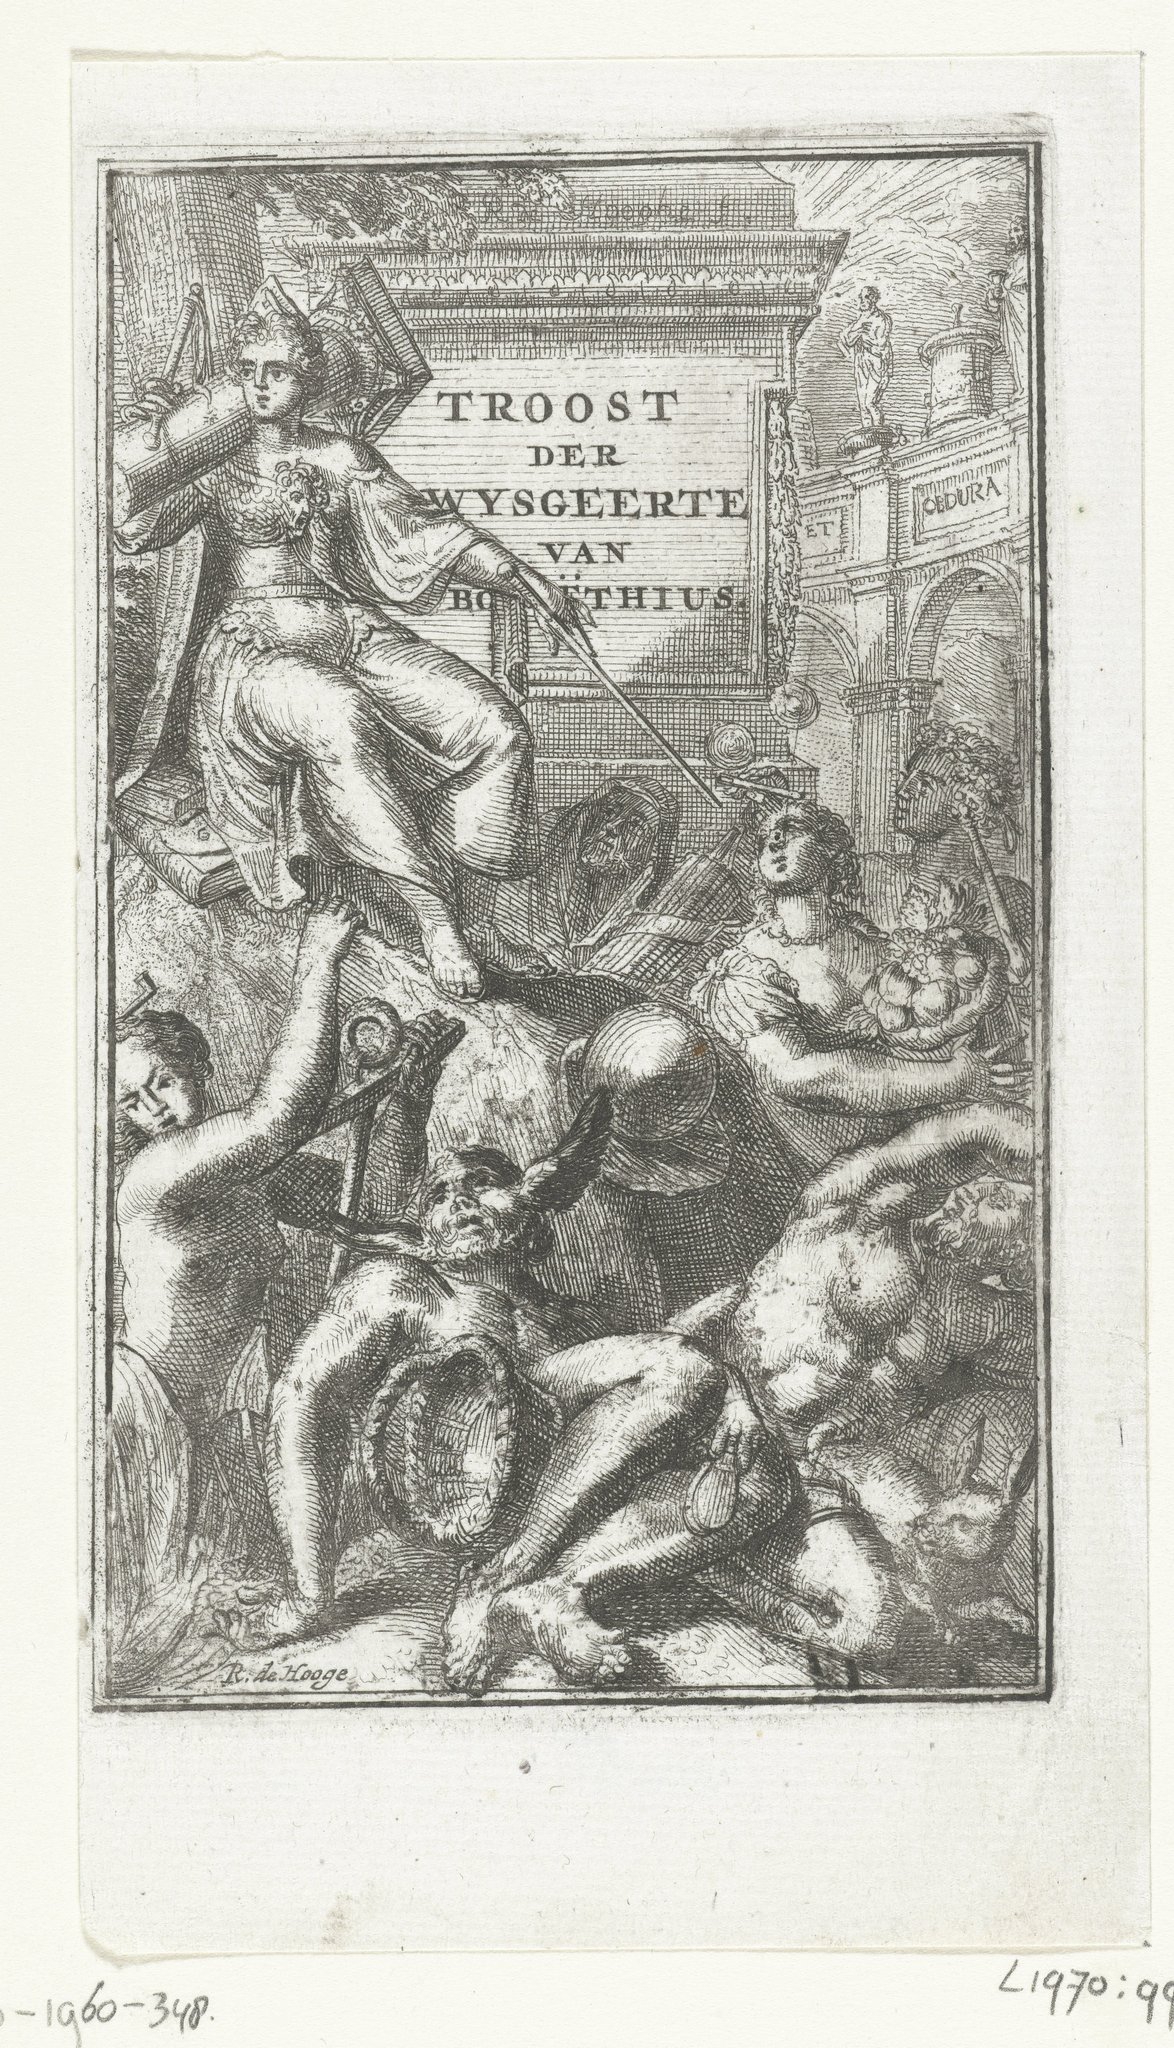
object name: print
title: Troost der wysgeerte van Boëthius.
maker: romeyn de hooghe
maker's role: draughtsman, goldsmith, painter, print maker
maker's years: 1645-1708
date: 1703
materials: paper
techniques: engraving, etching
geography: haarlem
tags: 'cornucopia', horn of plenty, hope, 'spes'; 'speranza divina e certa' (ripa) ~ one of the three theological virtues, 'philosophia'; 'filosofia' (ripa)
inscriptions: collector's mark: Lugt 2228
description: Titelprent voor: A.M.T.S. Boethius, 'Vertroostinge der wysgeerte' (Amsterdam: Adriaan Braakman en Gouda: Lucas Kloppenburg, 1703). Klinkert, C.